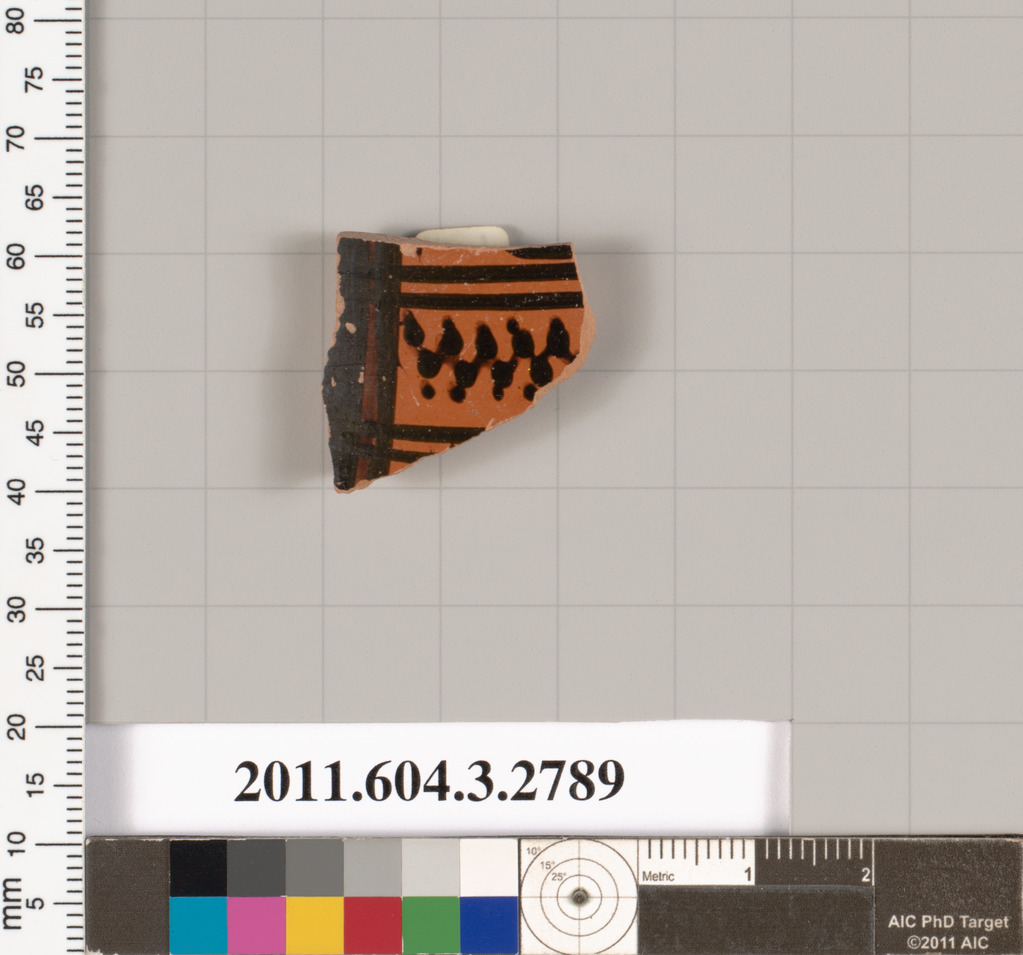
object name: olpe fragment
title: Terracotta fragment of an olpe (jug)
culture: greek, attic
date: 525-501 BCE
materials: terracotta